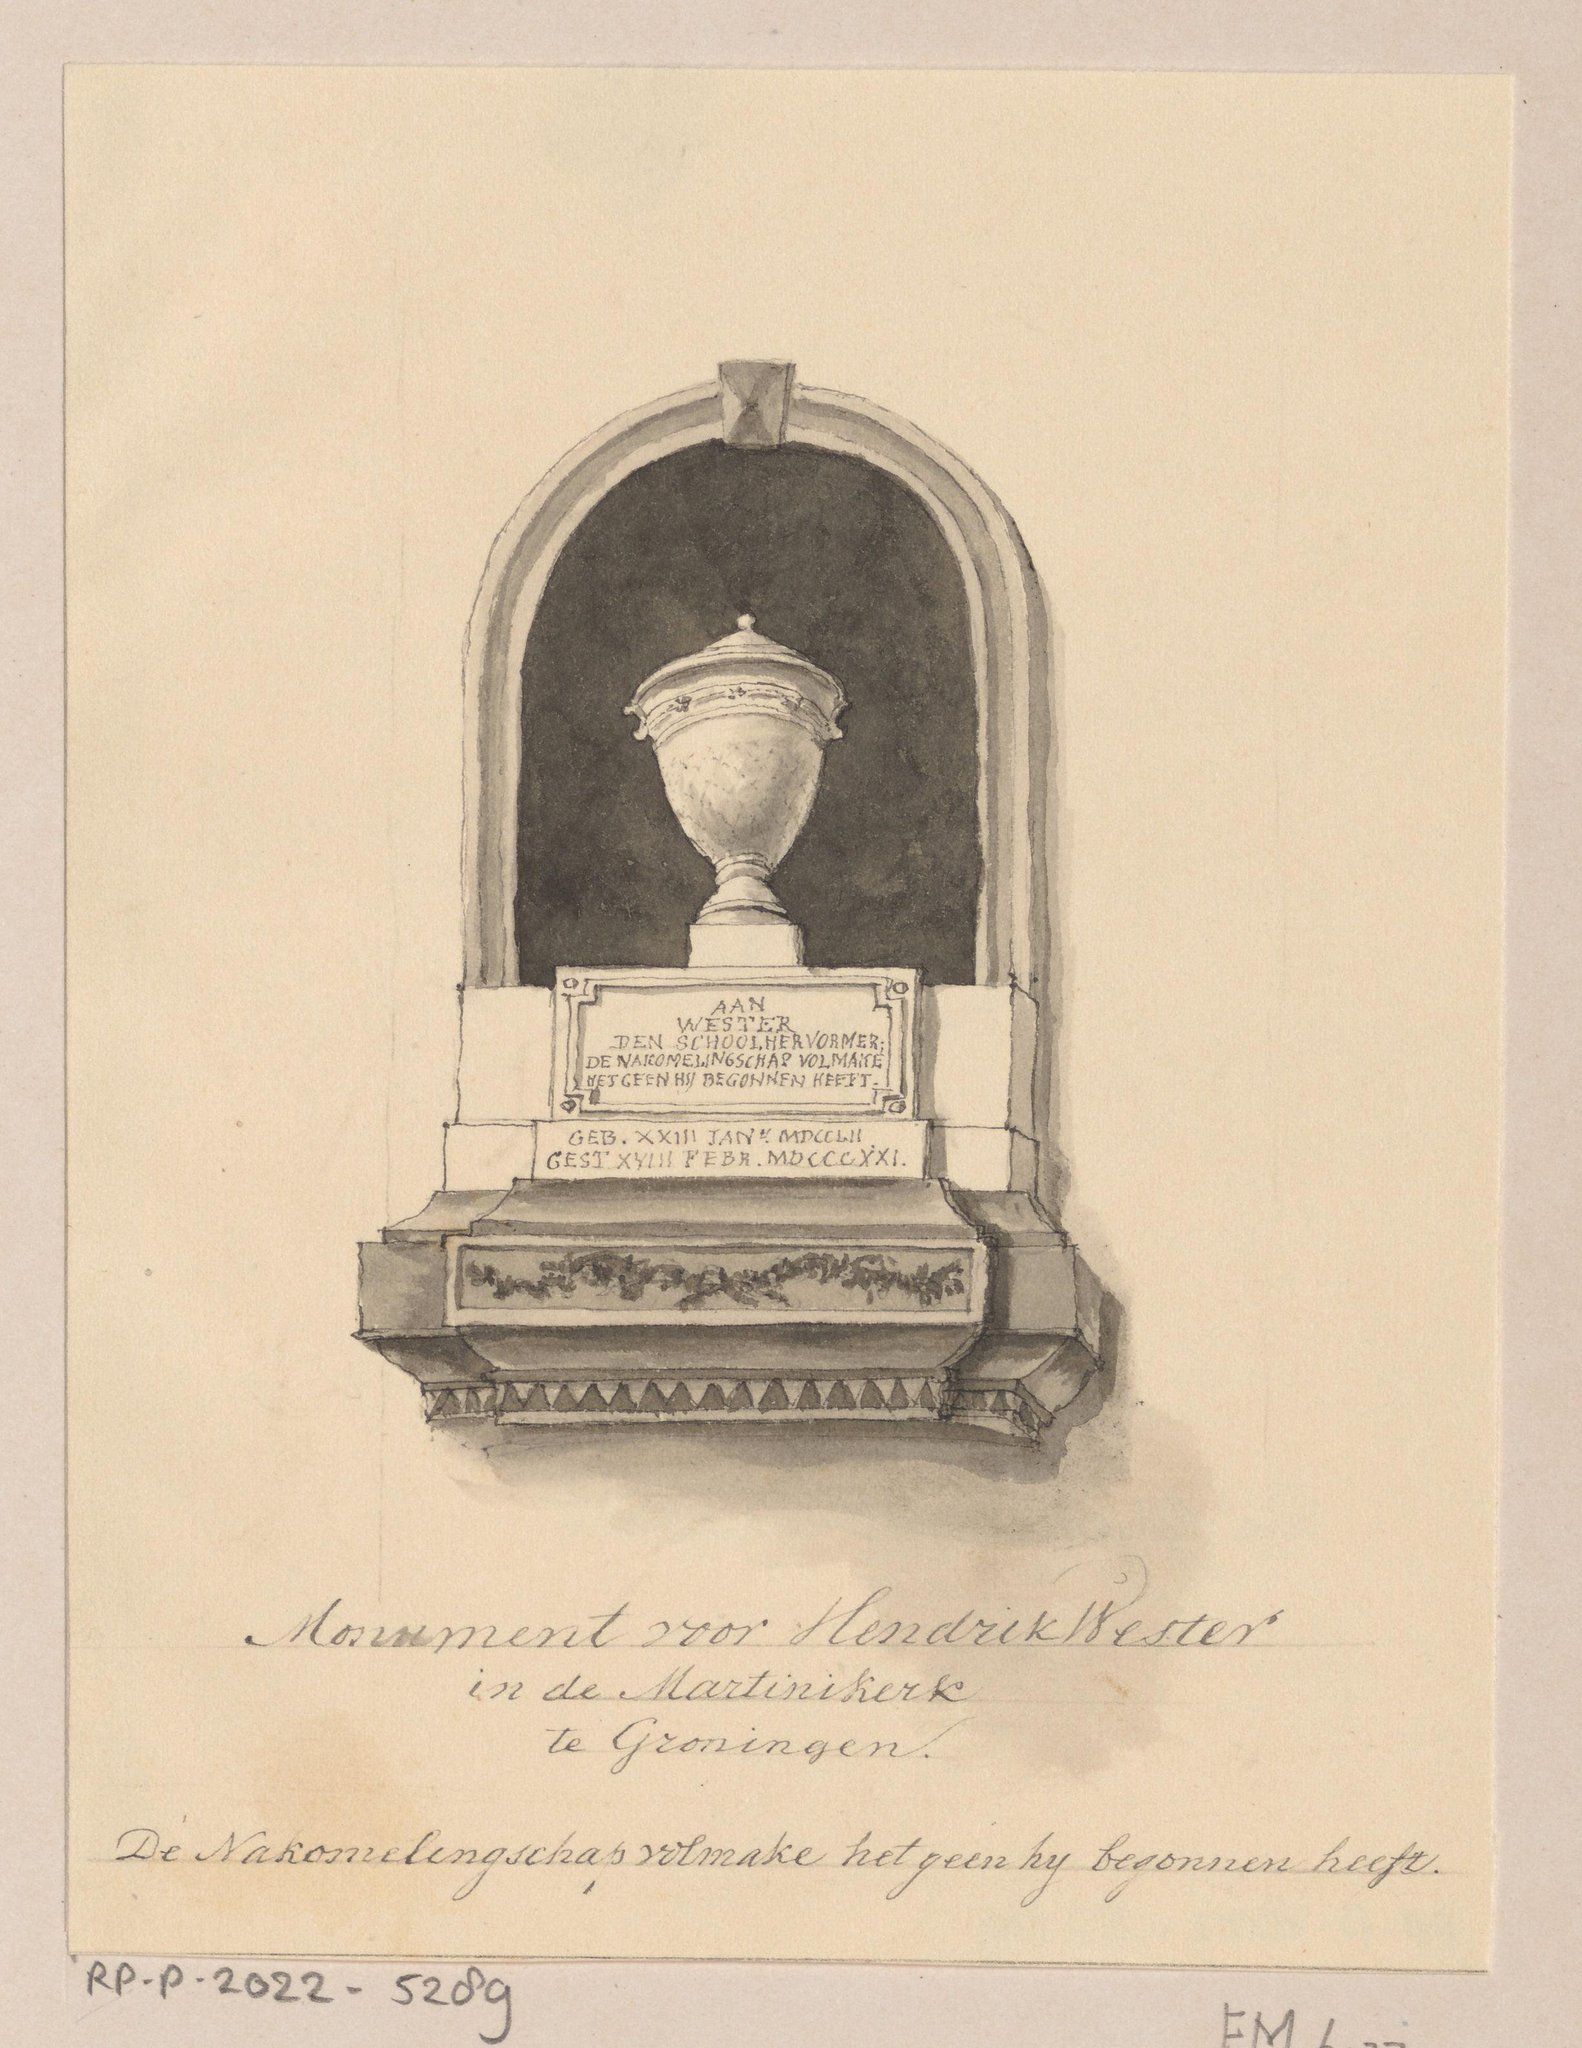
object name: drawing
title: Monument voor Hendrik Wester in de Martinikerk in Groningen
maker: gerrit lamberts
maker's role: bookseller, draughtsman, print maker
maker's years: 1776-1850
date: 1823-1850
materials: ink, paper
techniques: brush, pen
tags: monument, statue